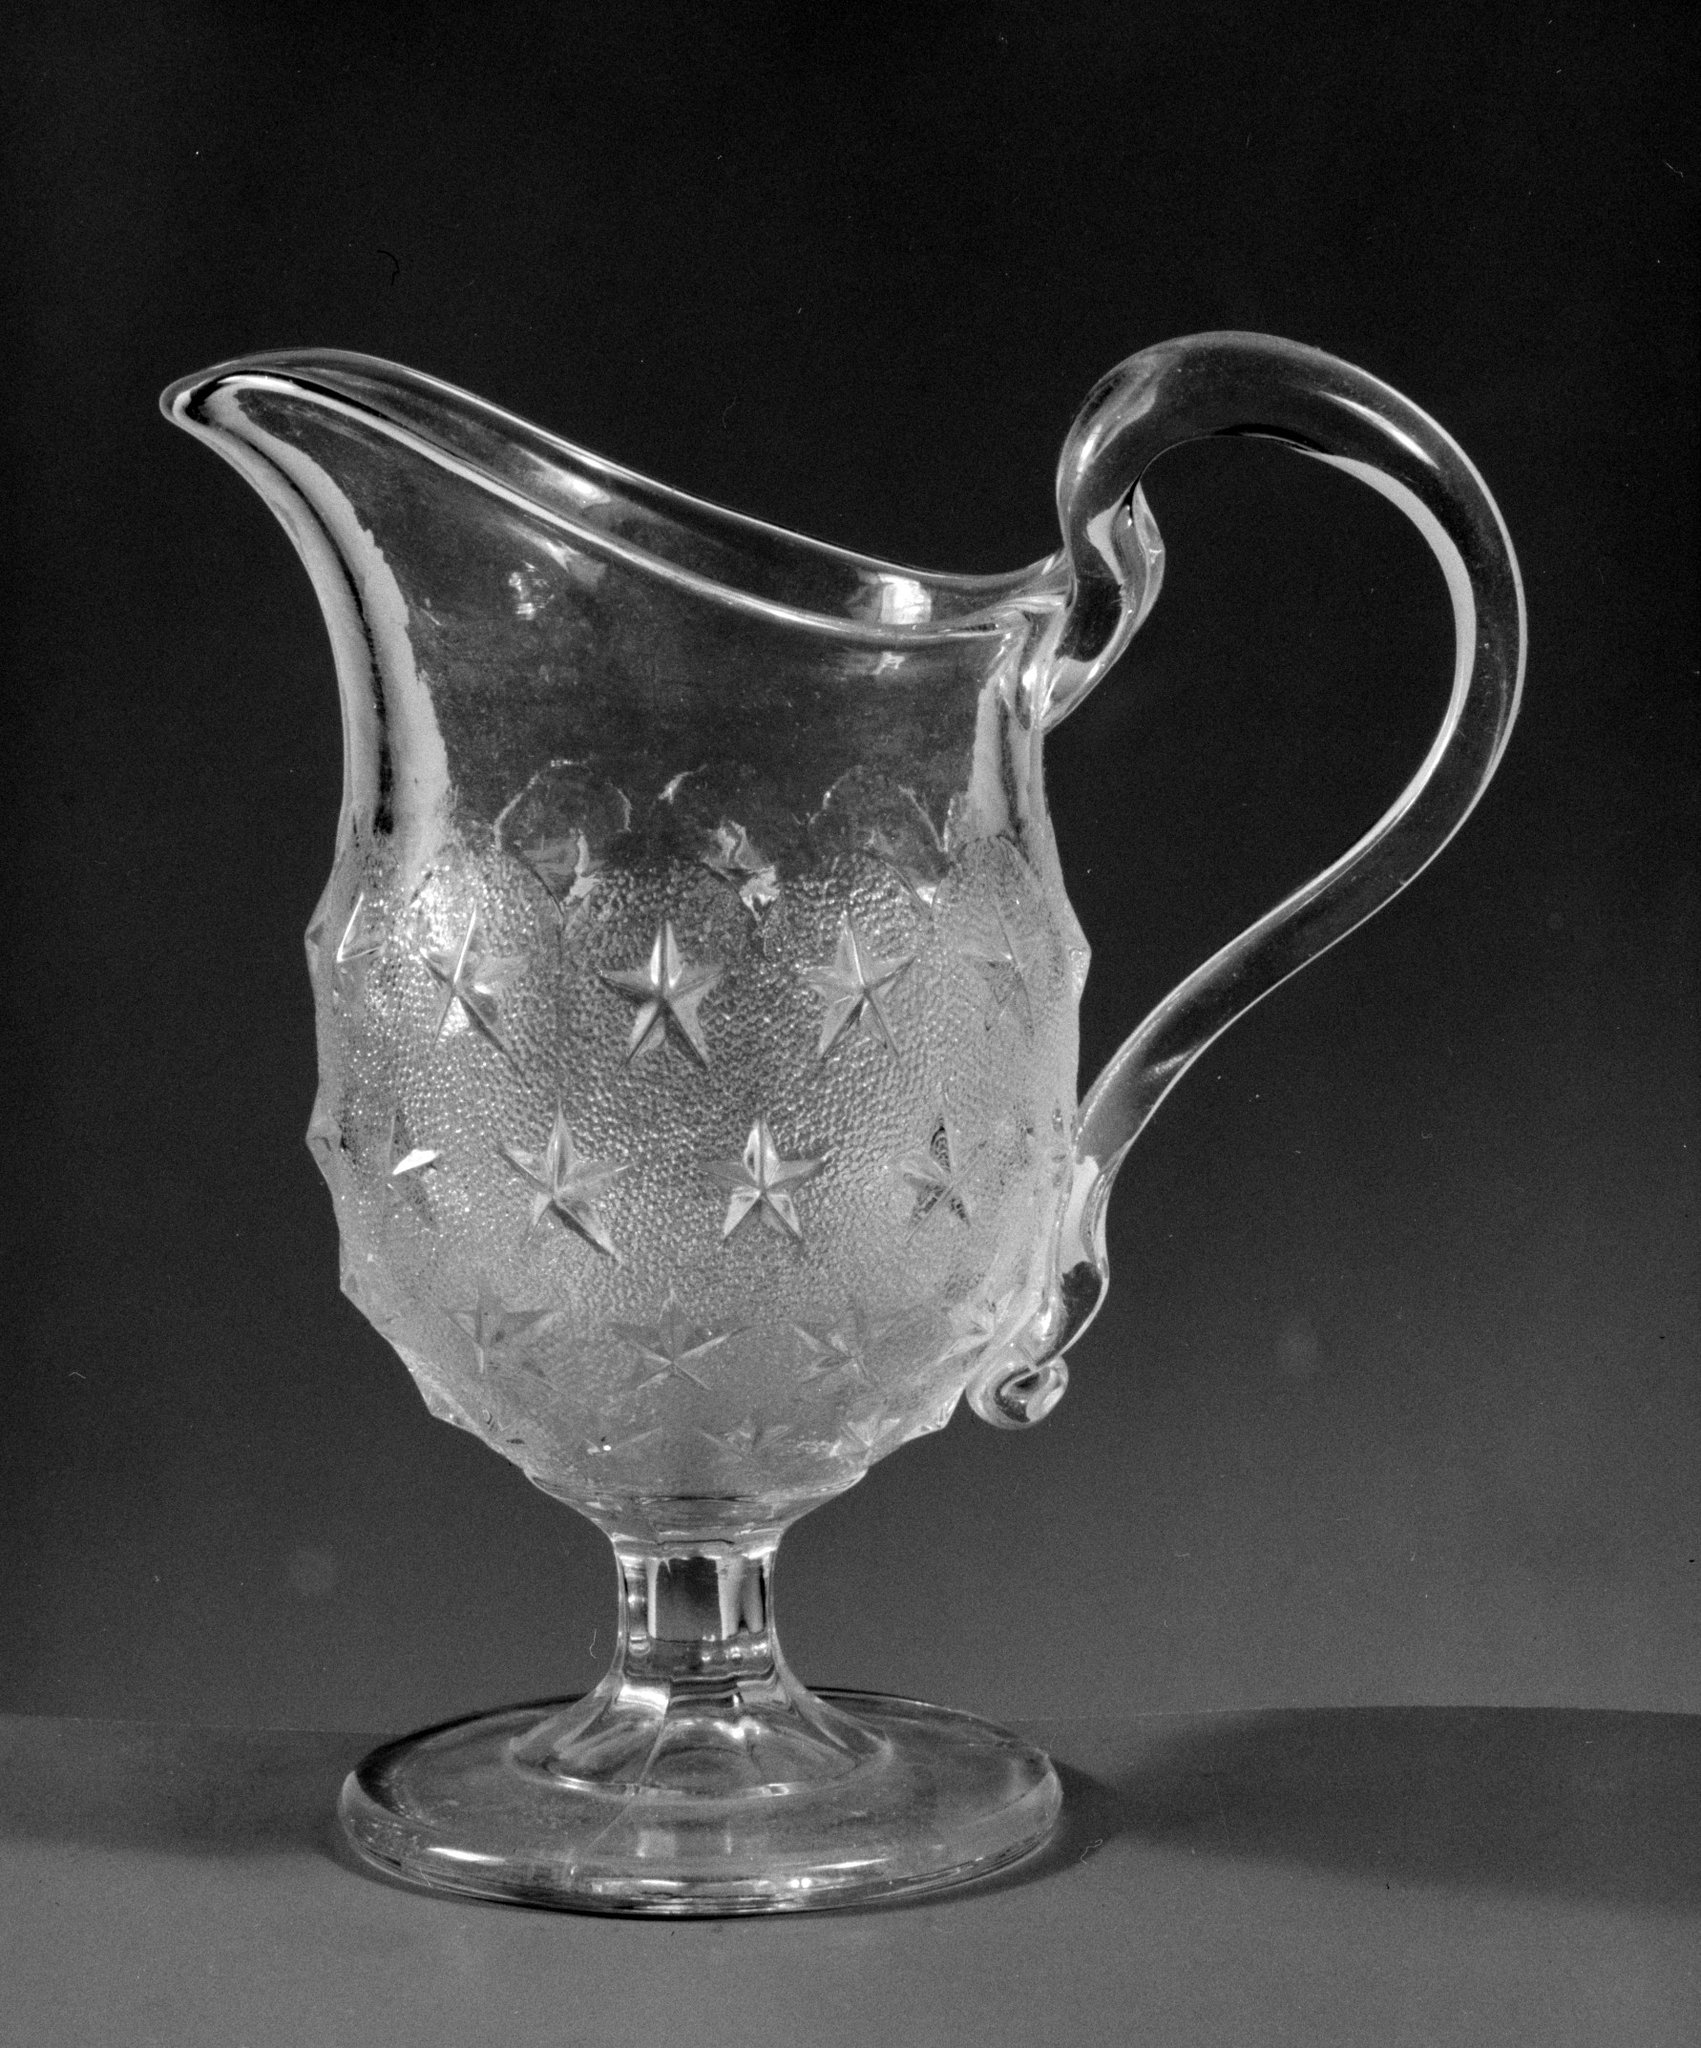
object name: cream pot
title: Creamer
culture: american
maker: james gillinder and sons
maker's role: maker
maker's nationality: american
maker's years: 1861-1930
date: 1876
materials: glass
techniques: pressed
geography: united states